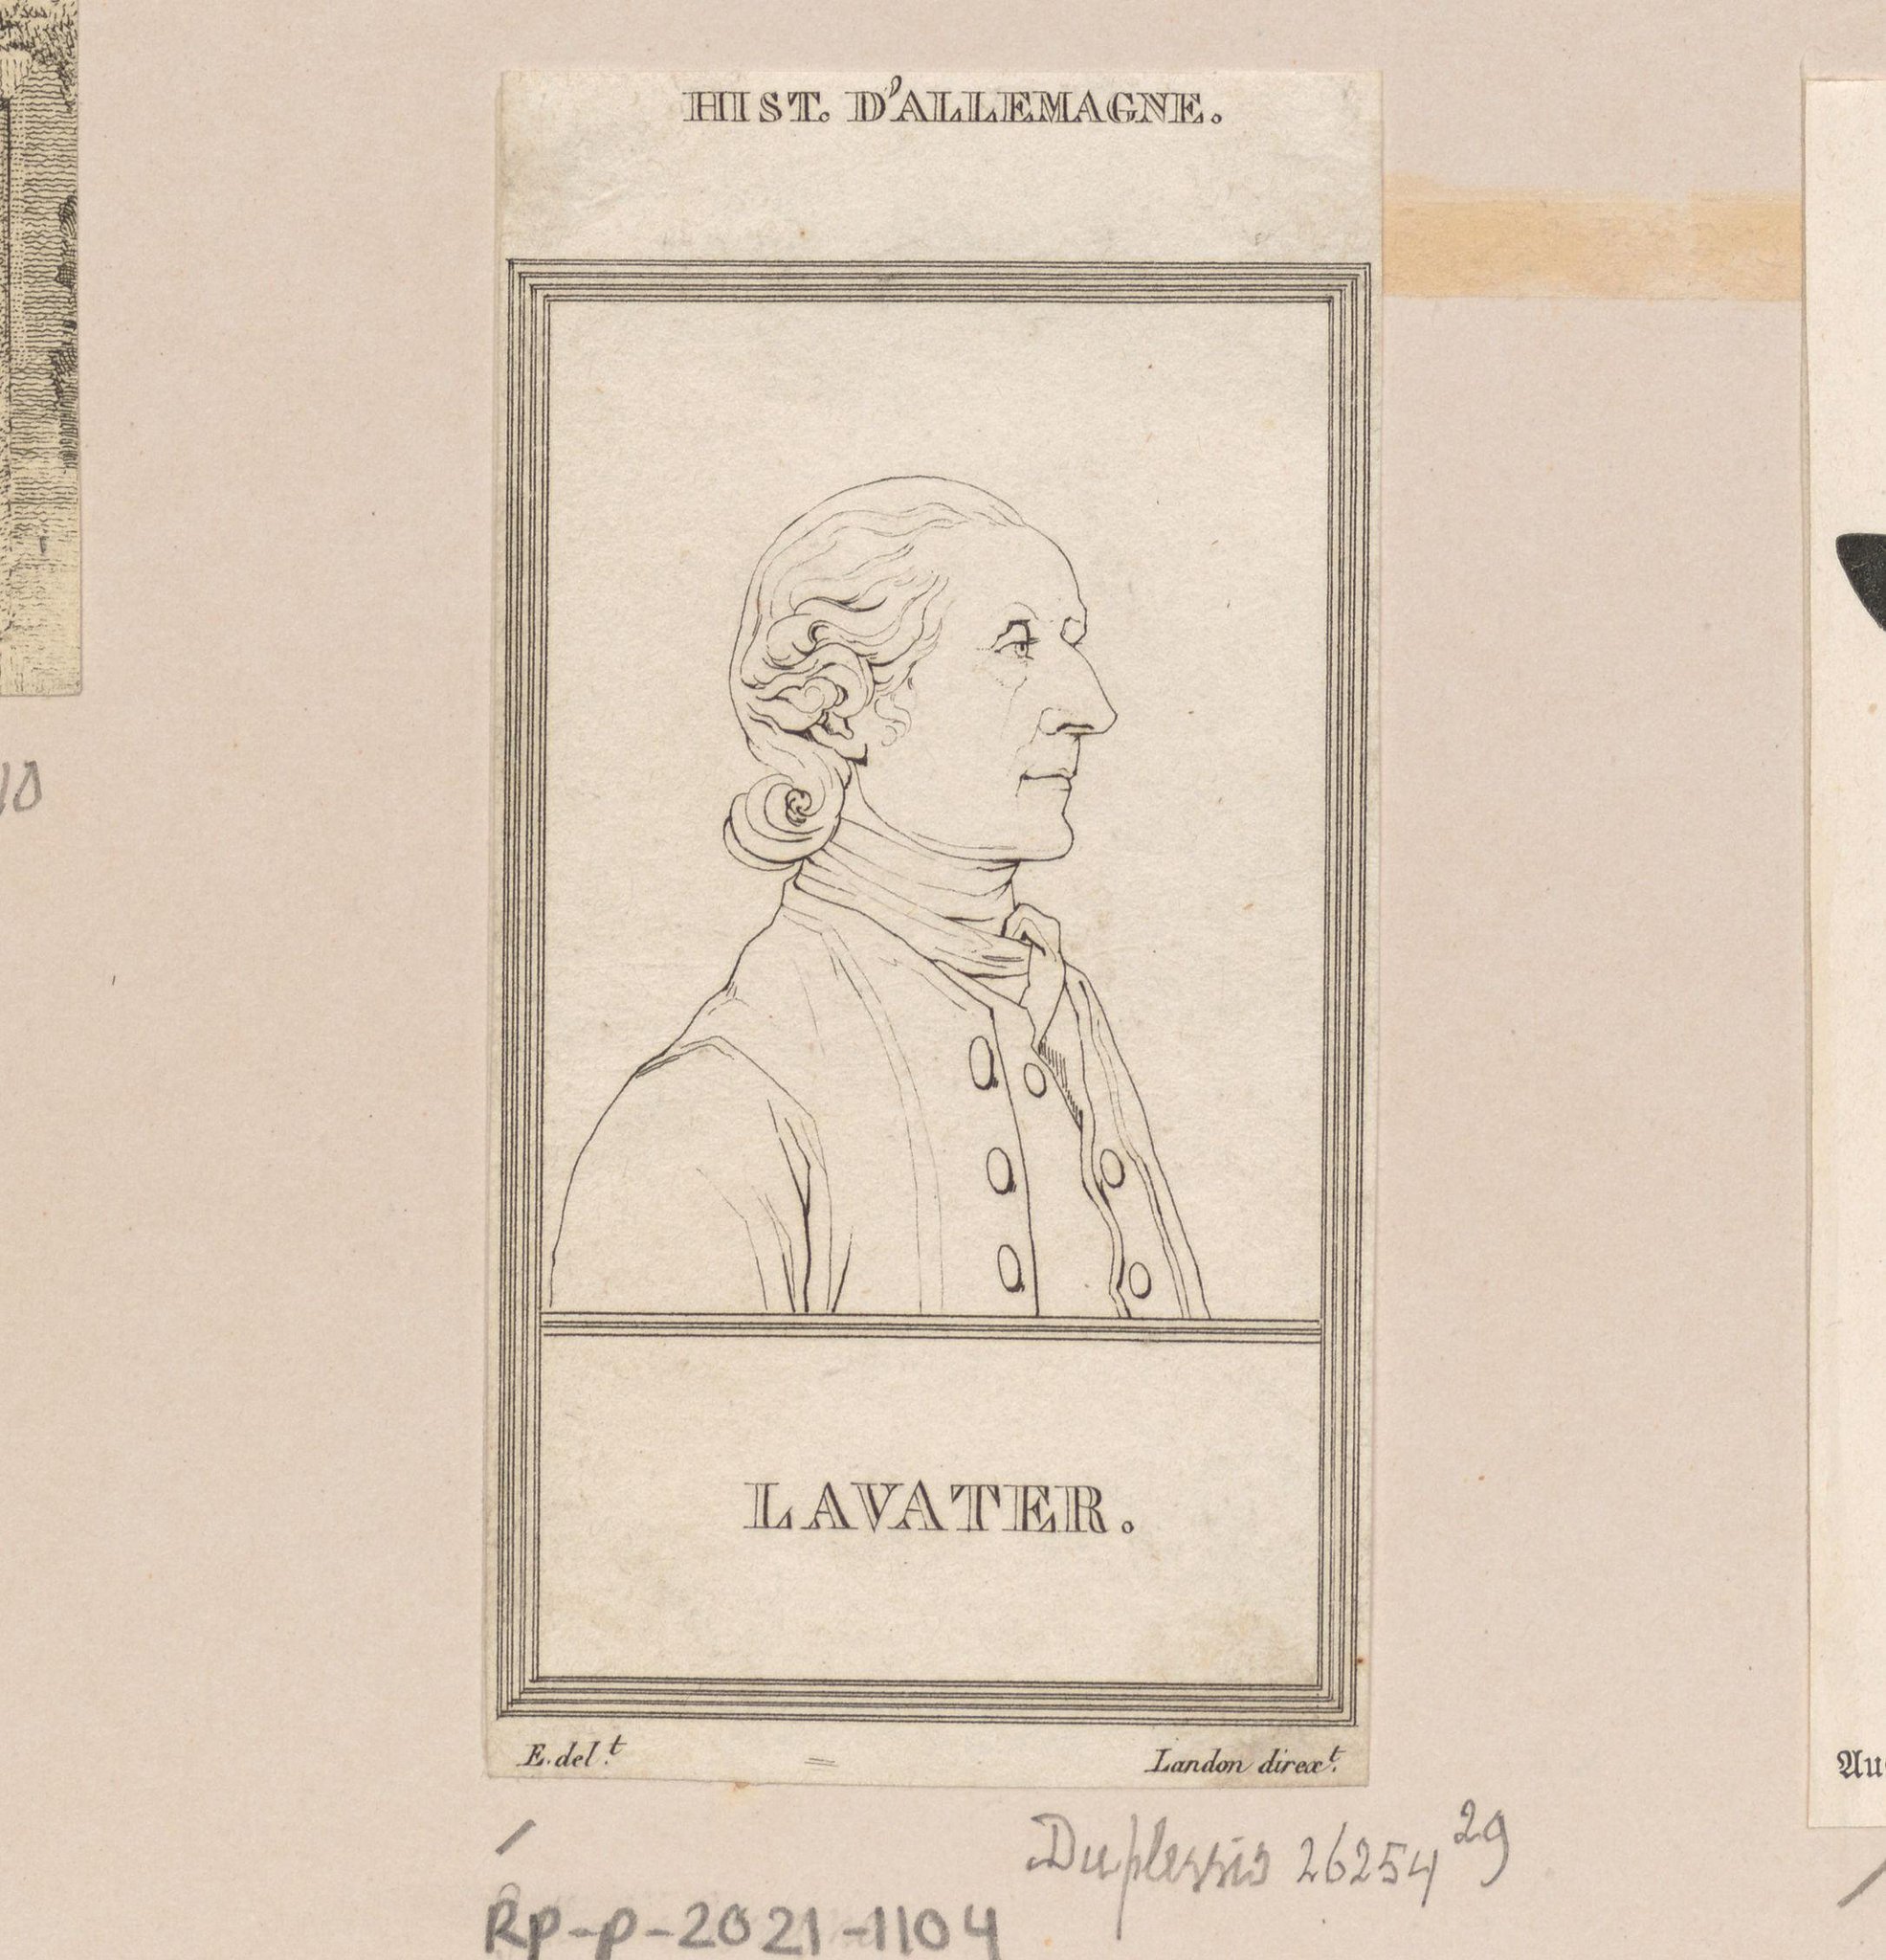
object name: book illustration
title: Portret van Johann Caspar Lavater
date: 1805-1811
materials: paper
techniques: etching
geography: france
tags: johann caspar lavater, historical persons, scholar, philosopher (+ portrait of scholar, scientist)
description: Prent waarschijnlijk uit een deel van: Galerie historique des hommes les plus celebres de tous les nations (...). Parijs: Charles Paul Landon, 1805-1811.